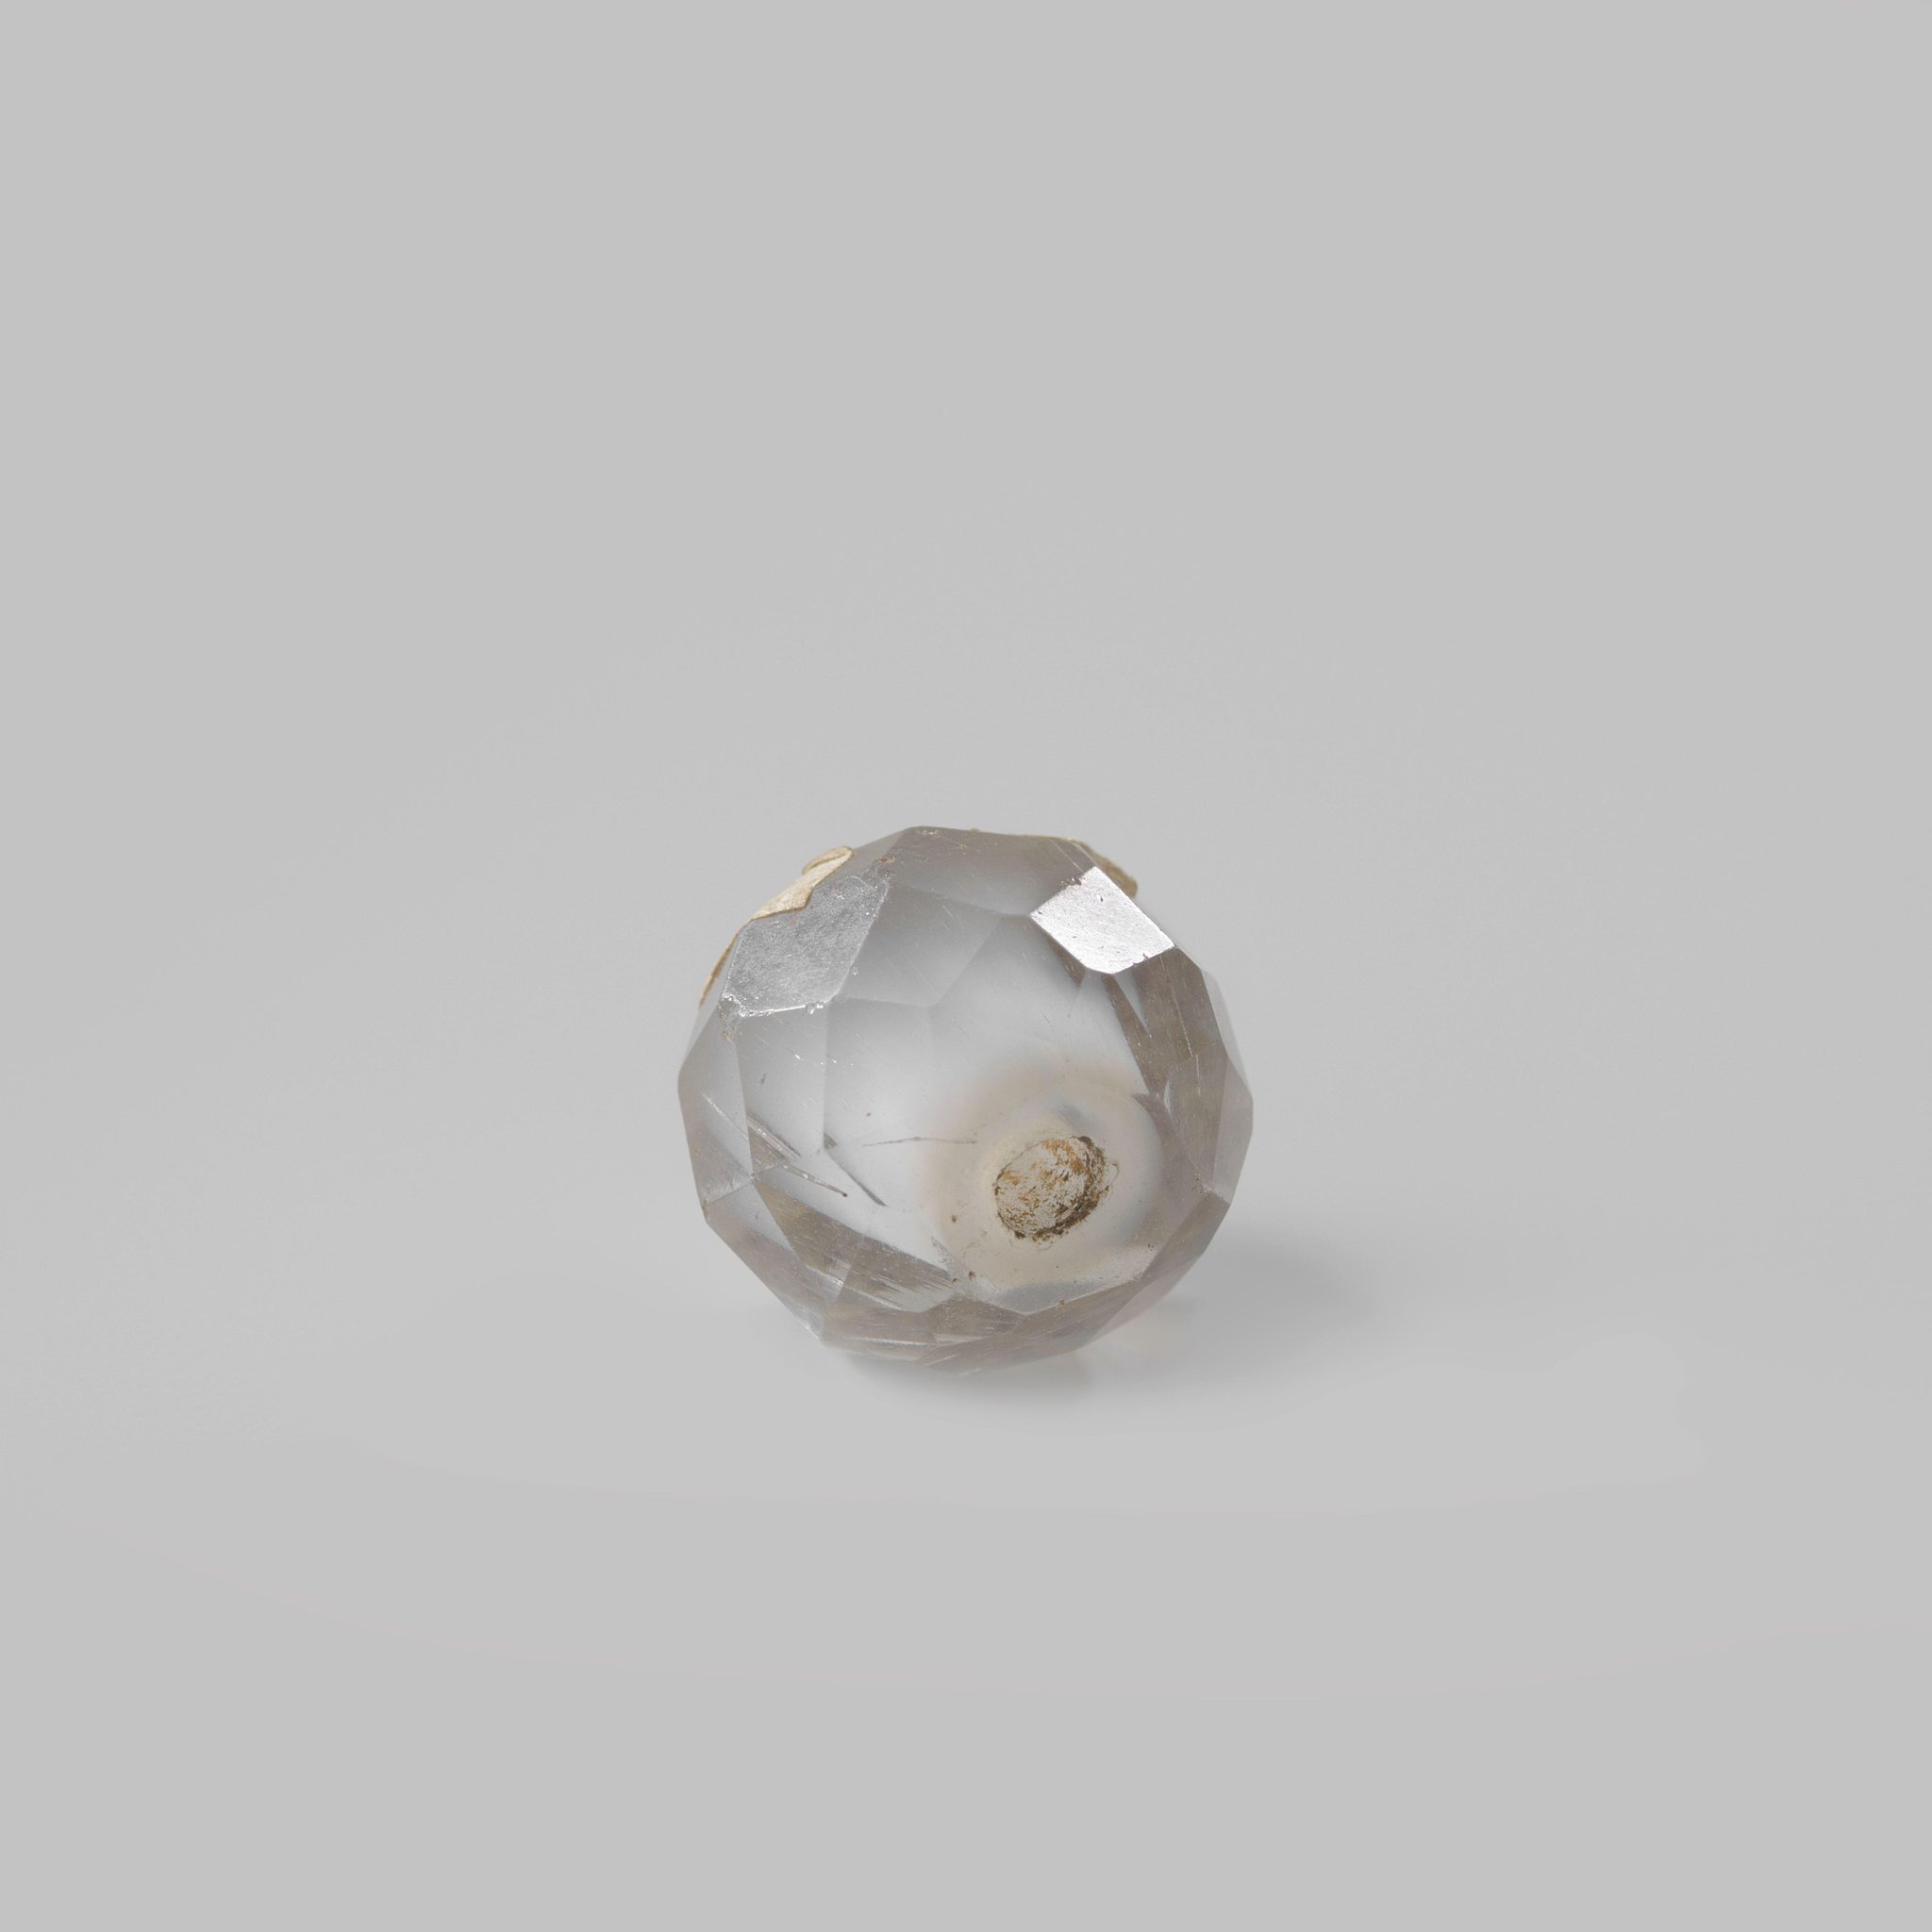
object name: bead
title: Witte kraal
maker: Anonymous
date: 1800-1900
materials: plastic